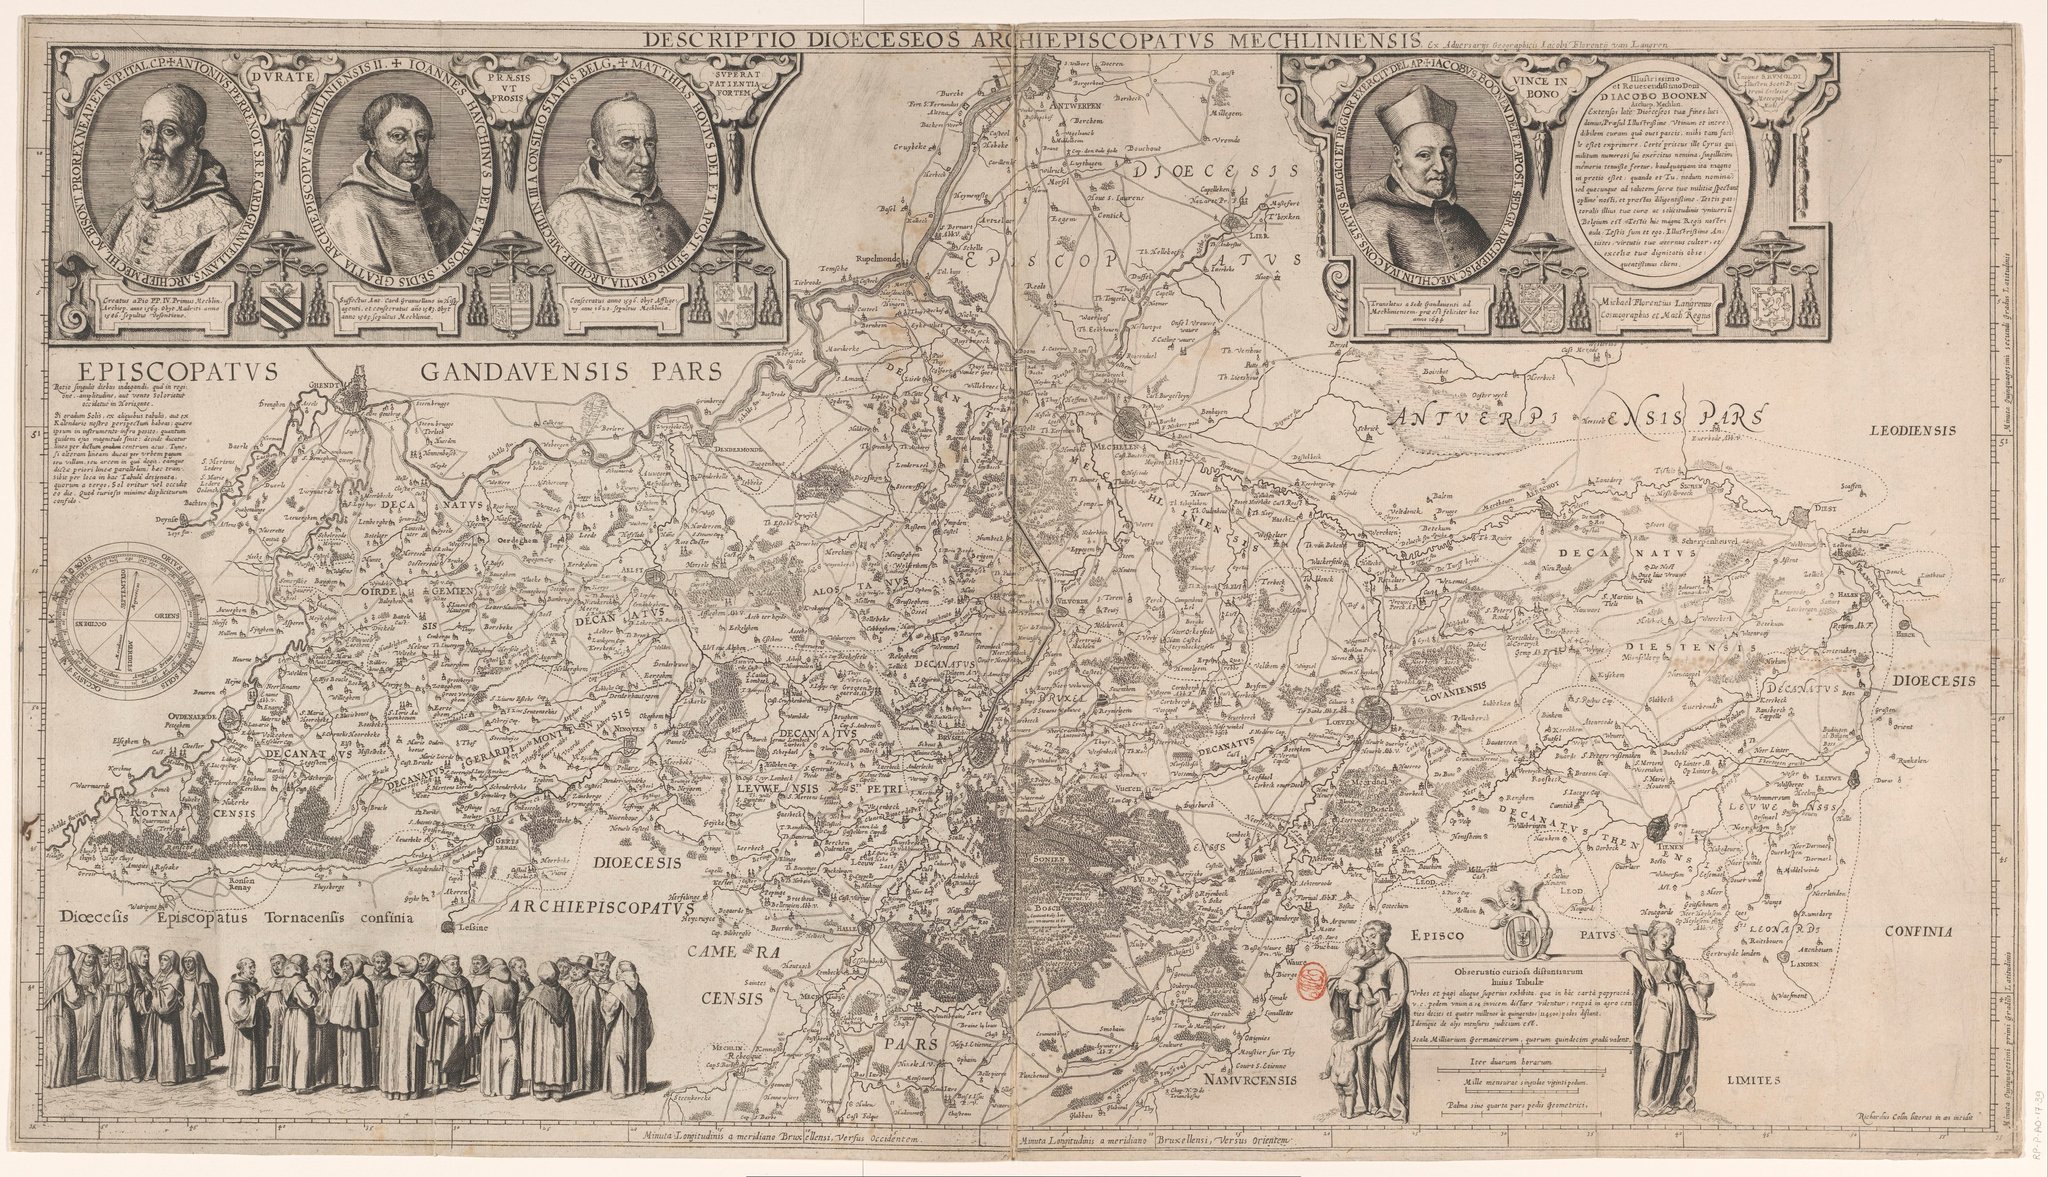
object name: map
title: Kaart van het aartsbisdom Mechelen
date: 1644-1655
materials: paper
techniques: engraving, etching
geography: mechelen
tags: nicolas perrenot de granvelle, jacob boonen, mechelen, johannes hauchinus, coat of arms (as symbol of the state, etc.) (+ city; municipal), archbishop, bishop, etc. (roman catholic), maps of separate countries or regions, monks and nuns, coat of arms (as symbol of the state, etc.) (+ province; provincial), armorial bearing, heraldry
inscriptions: collector's mark: Lugt 2228, collector's mark: Lugt 195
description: Kaart van het aartsbisdom Mechelen met in een balk boven de kaart de titel. Linksboven een inzet met, van links naar rechts, de portretten en wapens van Antonius Perrenot de Granvelle, Joannes Hauchinius en Matthias Hovius, voormalig aartsbisschoppen van Mechelen. Rechtsboven een inzet met het portret en wapen van Jacobus Boonen, aartsbisschop van Mechelen. Naast het portret een opdracht aan Jacobus van Boonen en een wapen dat aan Sint-Rombout, de beschermheilige van Mechelen, toe zou behoren. Linksonder een groep geestelijken. Onder, rechts van het midden, een cartouche met vier schaalstokken: 2 Scala Milliarium Germanicorum, quorum quindecim gradu valent / Iter duarum horarum / 1 Mille mensurae singulae vigintipedum / 1 Palma sive quarta pars pedis Geometrici. Op de cartouche een putto met het wapen van Mechelen. Links en rechts van de cartouche de personificaties van Caritas en Fides. De kaart is voorzien van een gradenverdeling langs de randen.